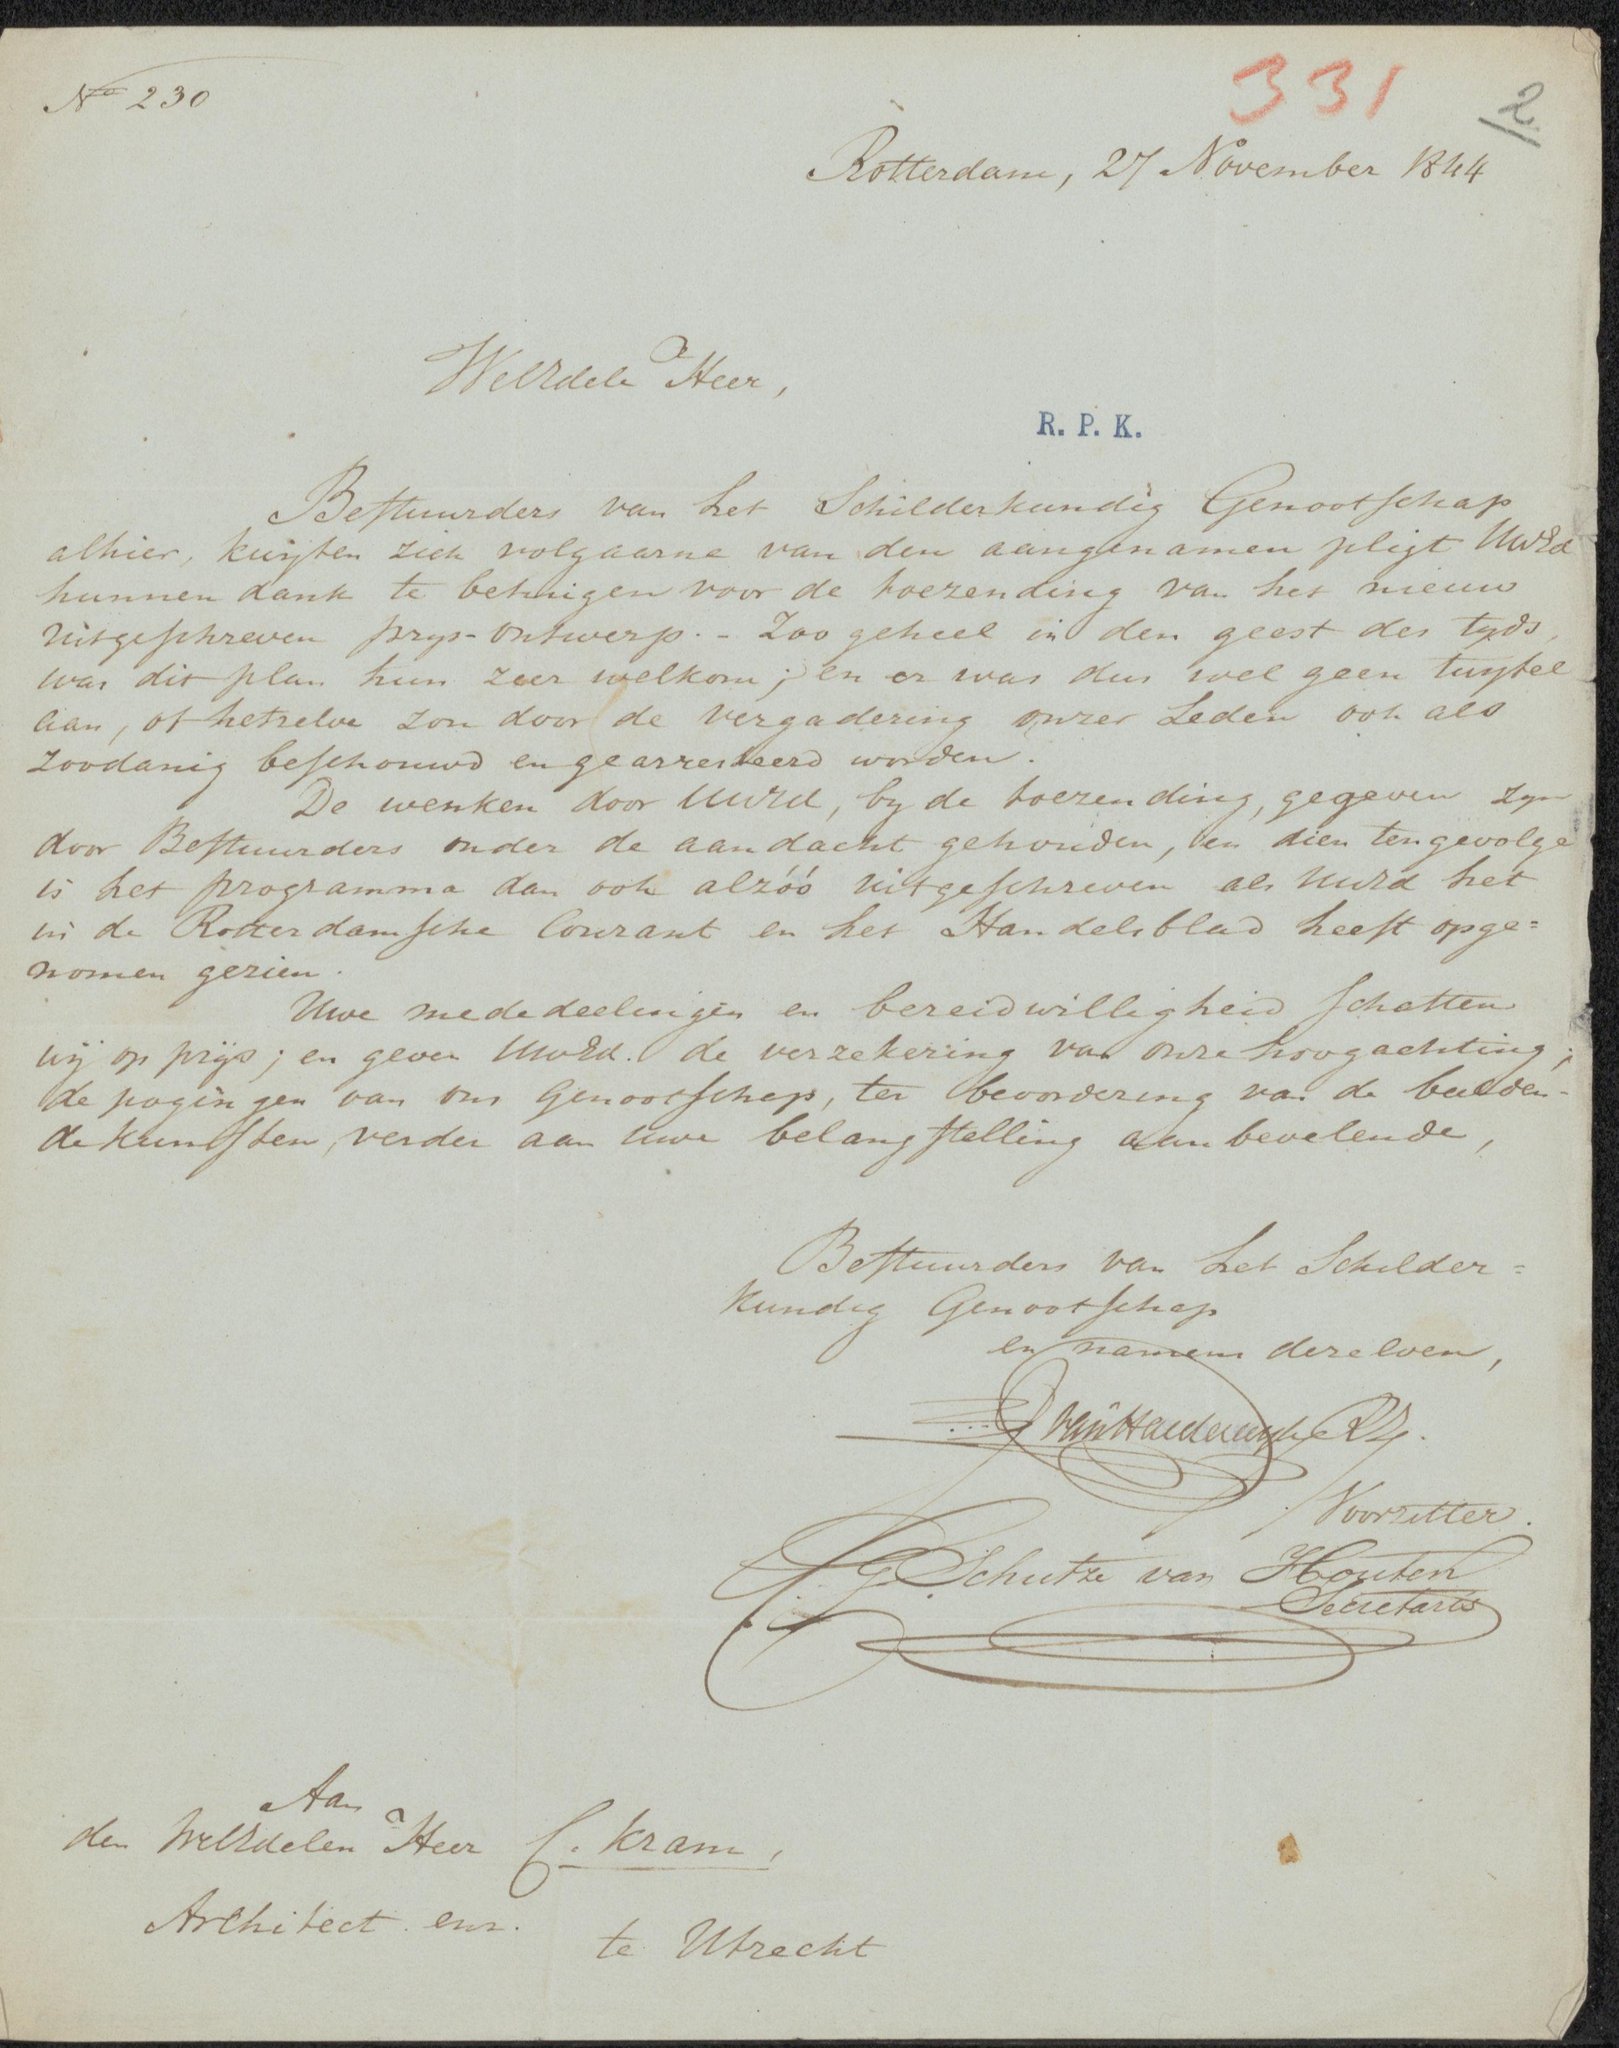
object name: letter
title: Brief aan Christiaan Kramm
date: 1844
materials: ink, paper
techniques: pen, writing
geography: rotterdam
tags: utrecht, print maker, draughtsman, christiaan kramm, distribution of awards ~ art contest, architecture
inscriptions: collector's mark: Lugt 2233